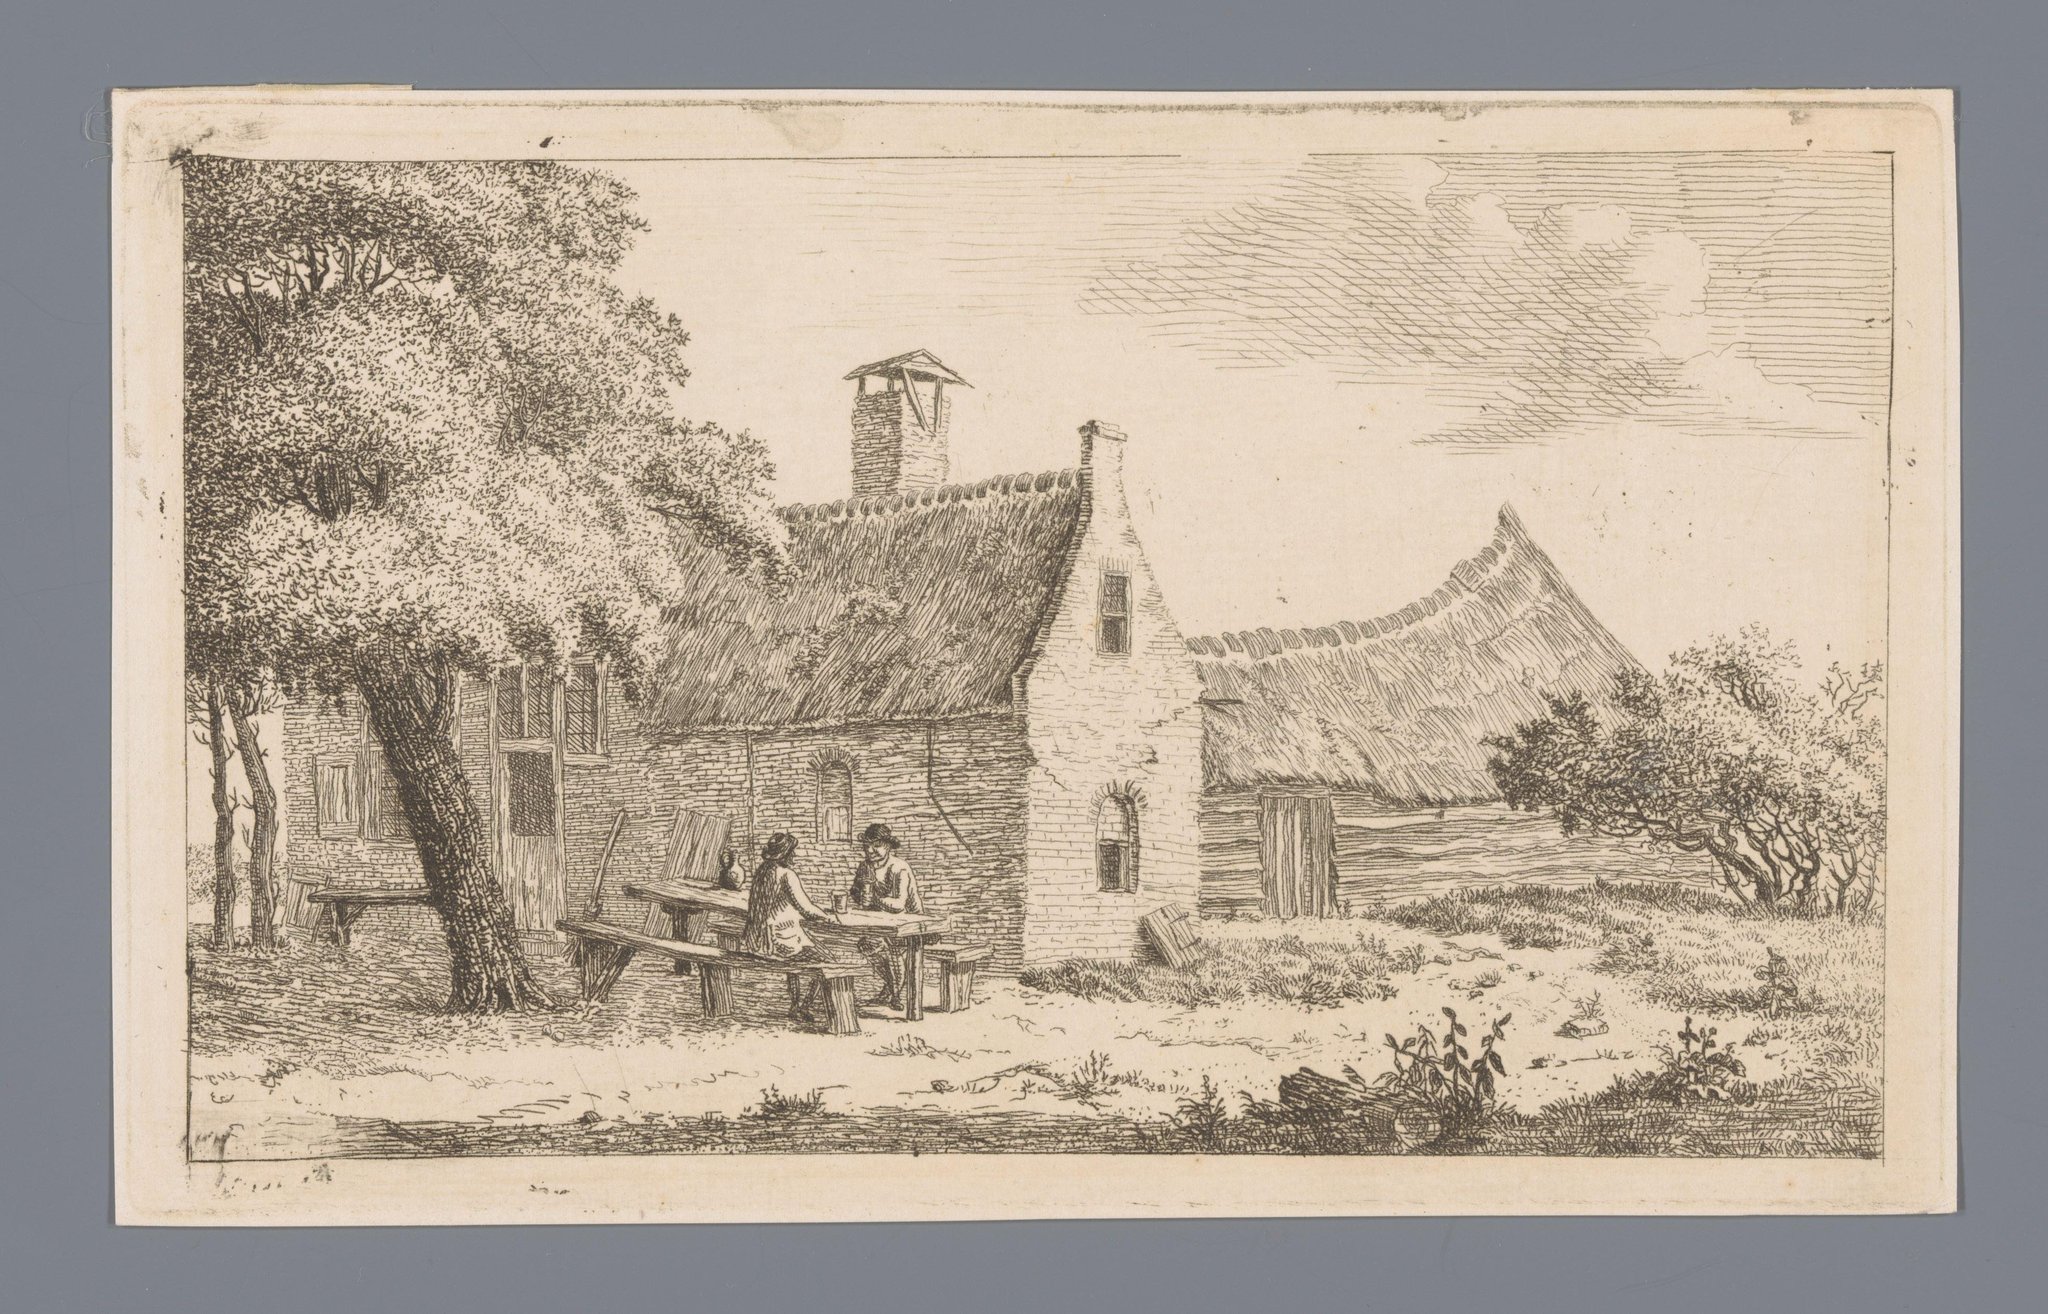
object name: print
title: Twee mannen aan een tafel voor herberg het Molentje aan de Amstel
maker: anthonie van den bos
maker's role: draughtsman, print maker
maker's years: 1763-1838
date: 1810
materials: paper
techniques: etching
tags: inn, coffee-house, public house, etc.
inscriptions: collector's mark: Lugt 2233